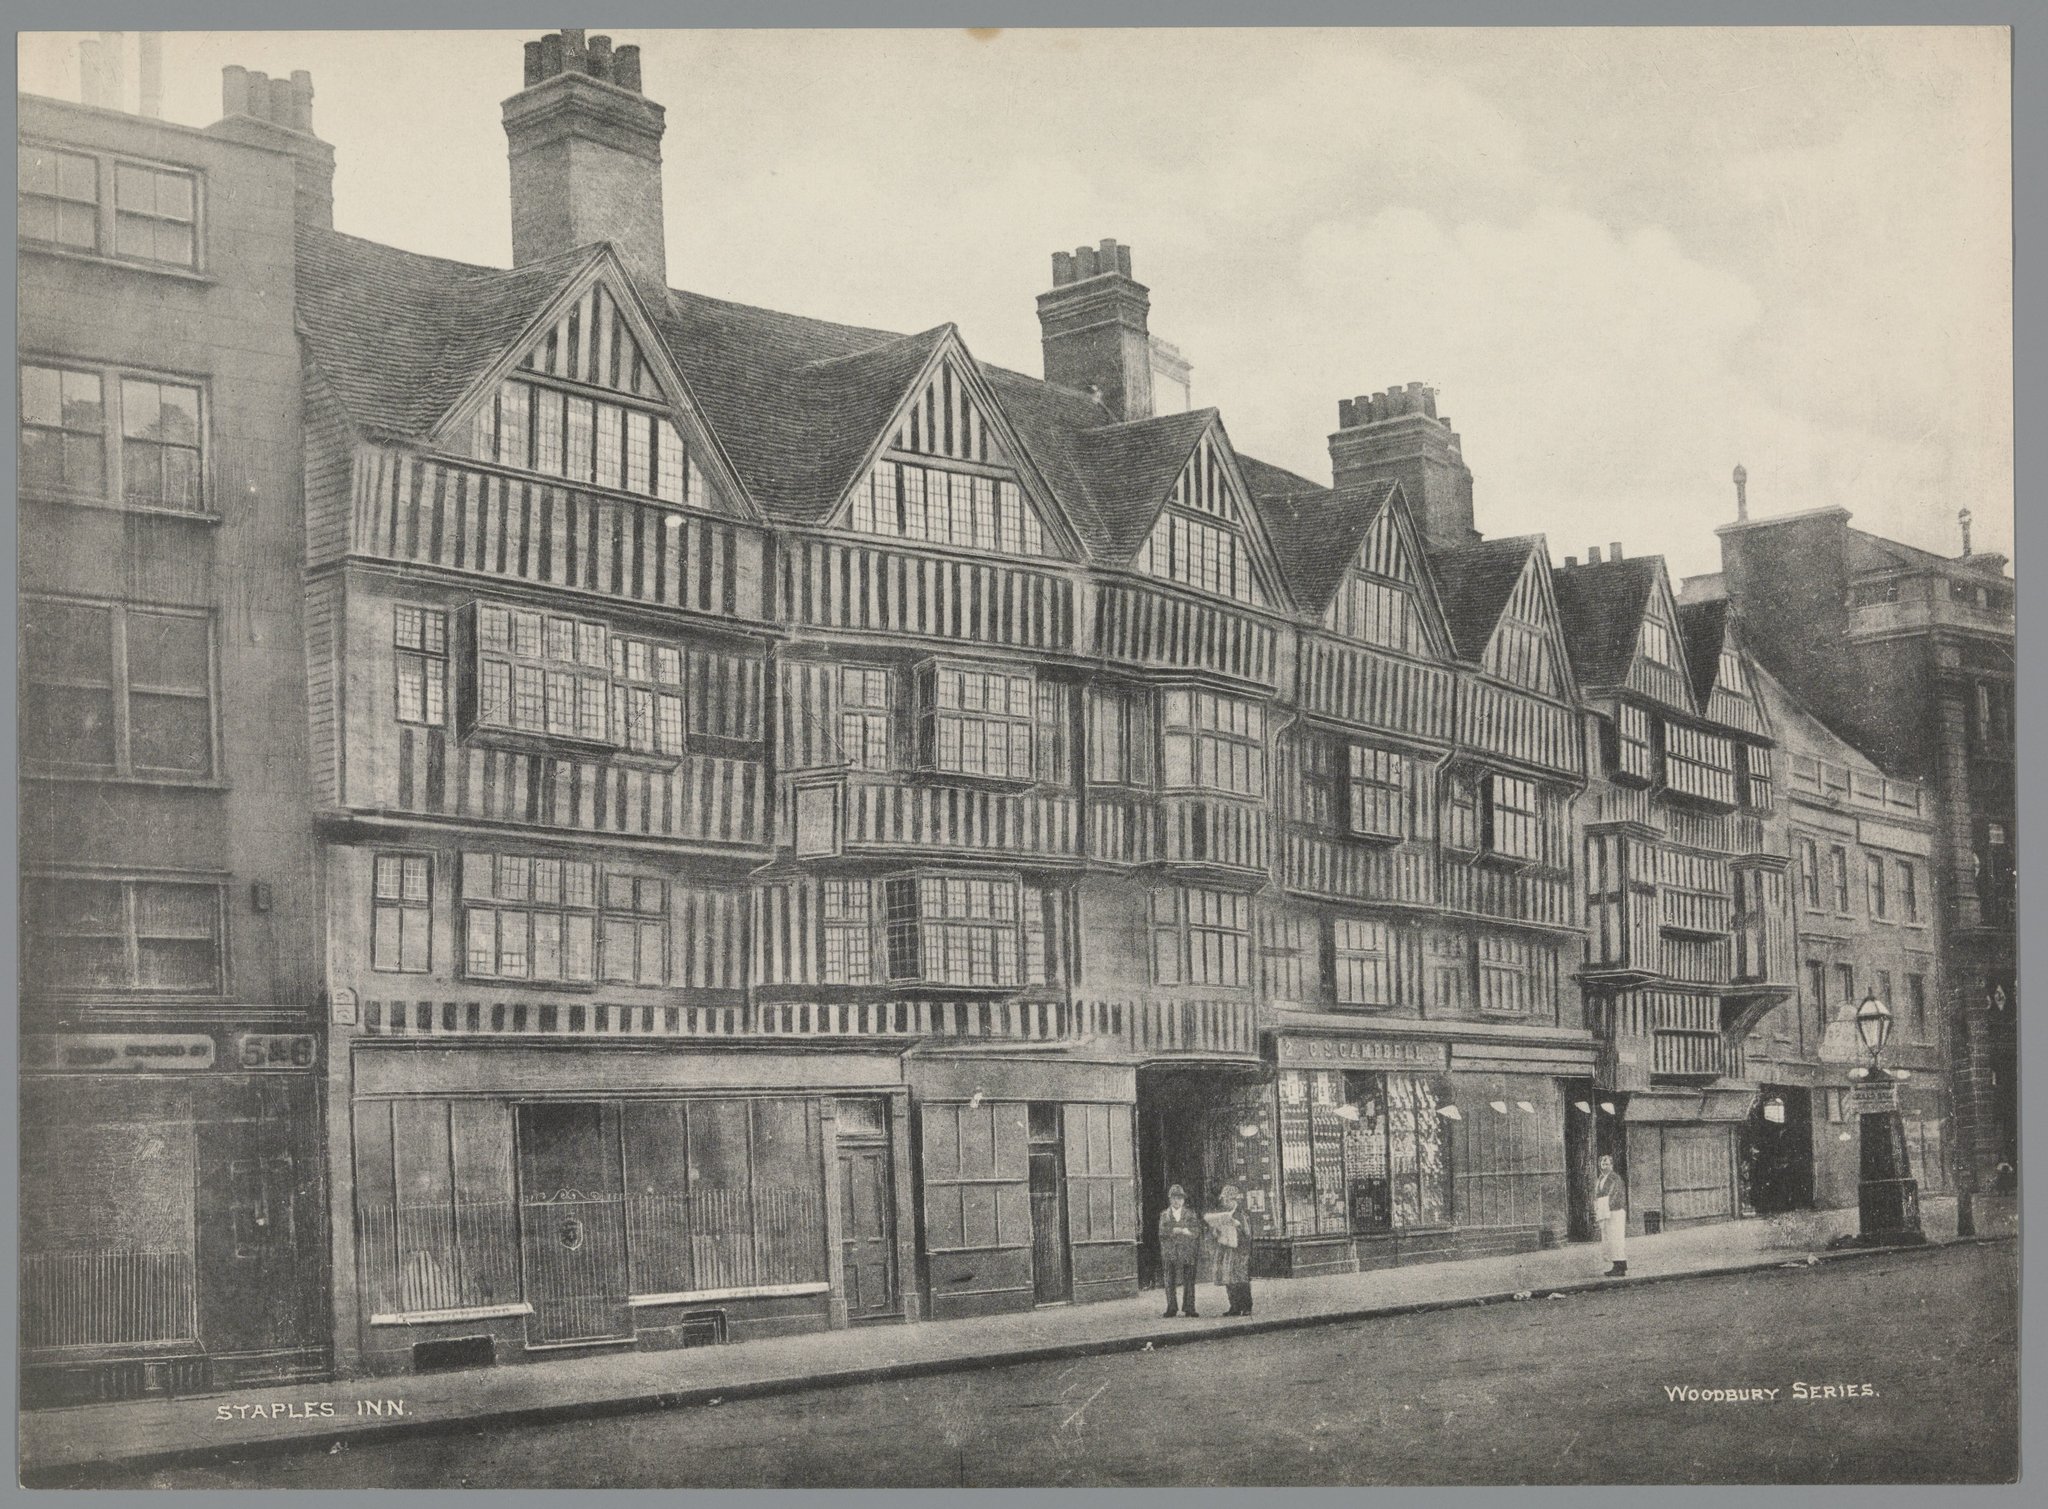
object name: print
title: Stadsgezicht van Londen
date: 1860-1915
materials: paper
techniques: photograph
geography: united kingdom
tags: london